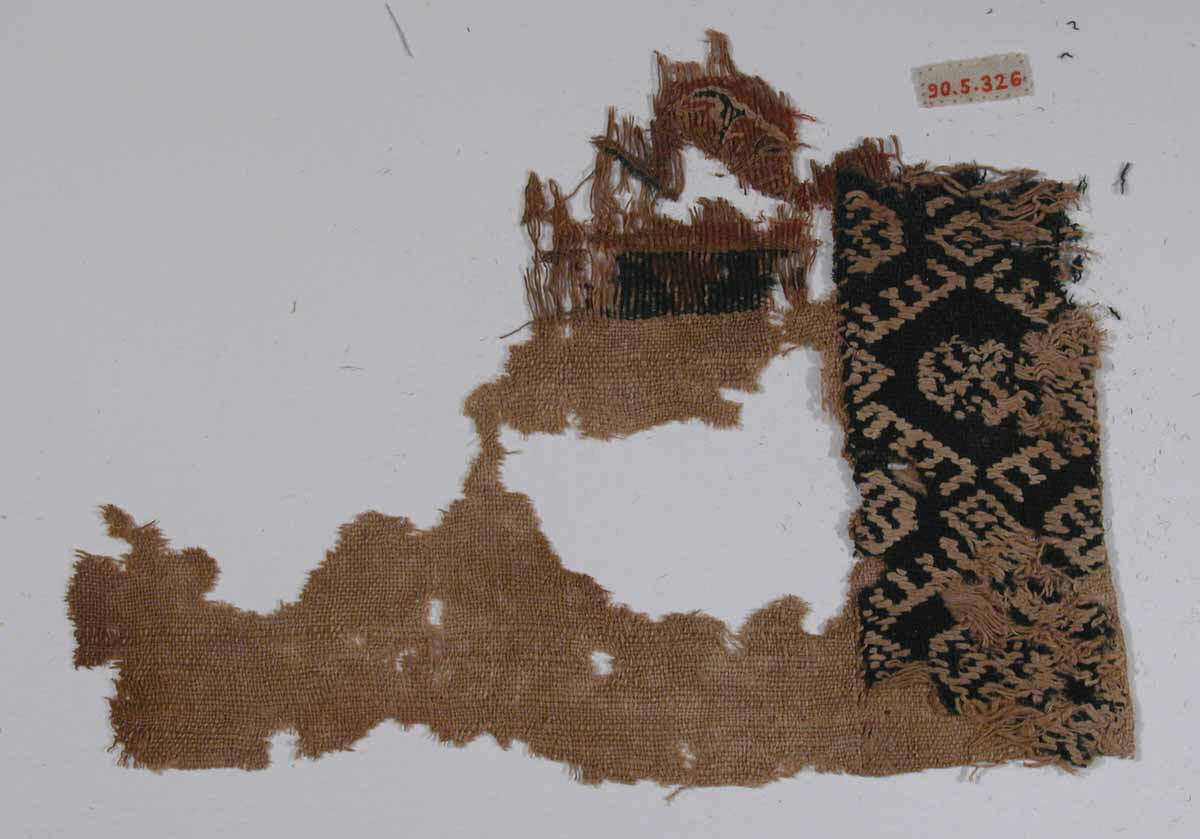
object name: textile fragment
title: Fragment of a Sleeve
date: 401-600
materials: linen, wool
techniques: weave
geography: egypt